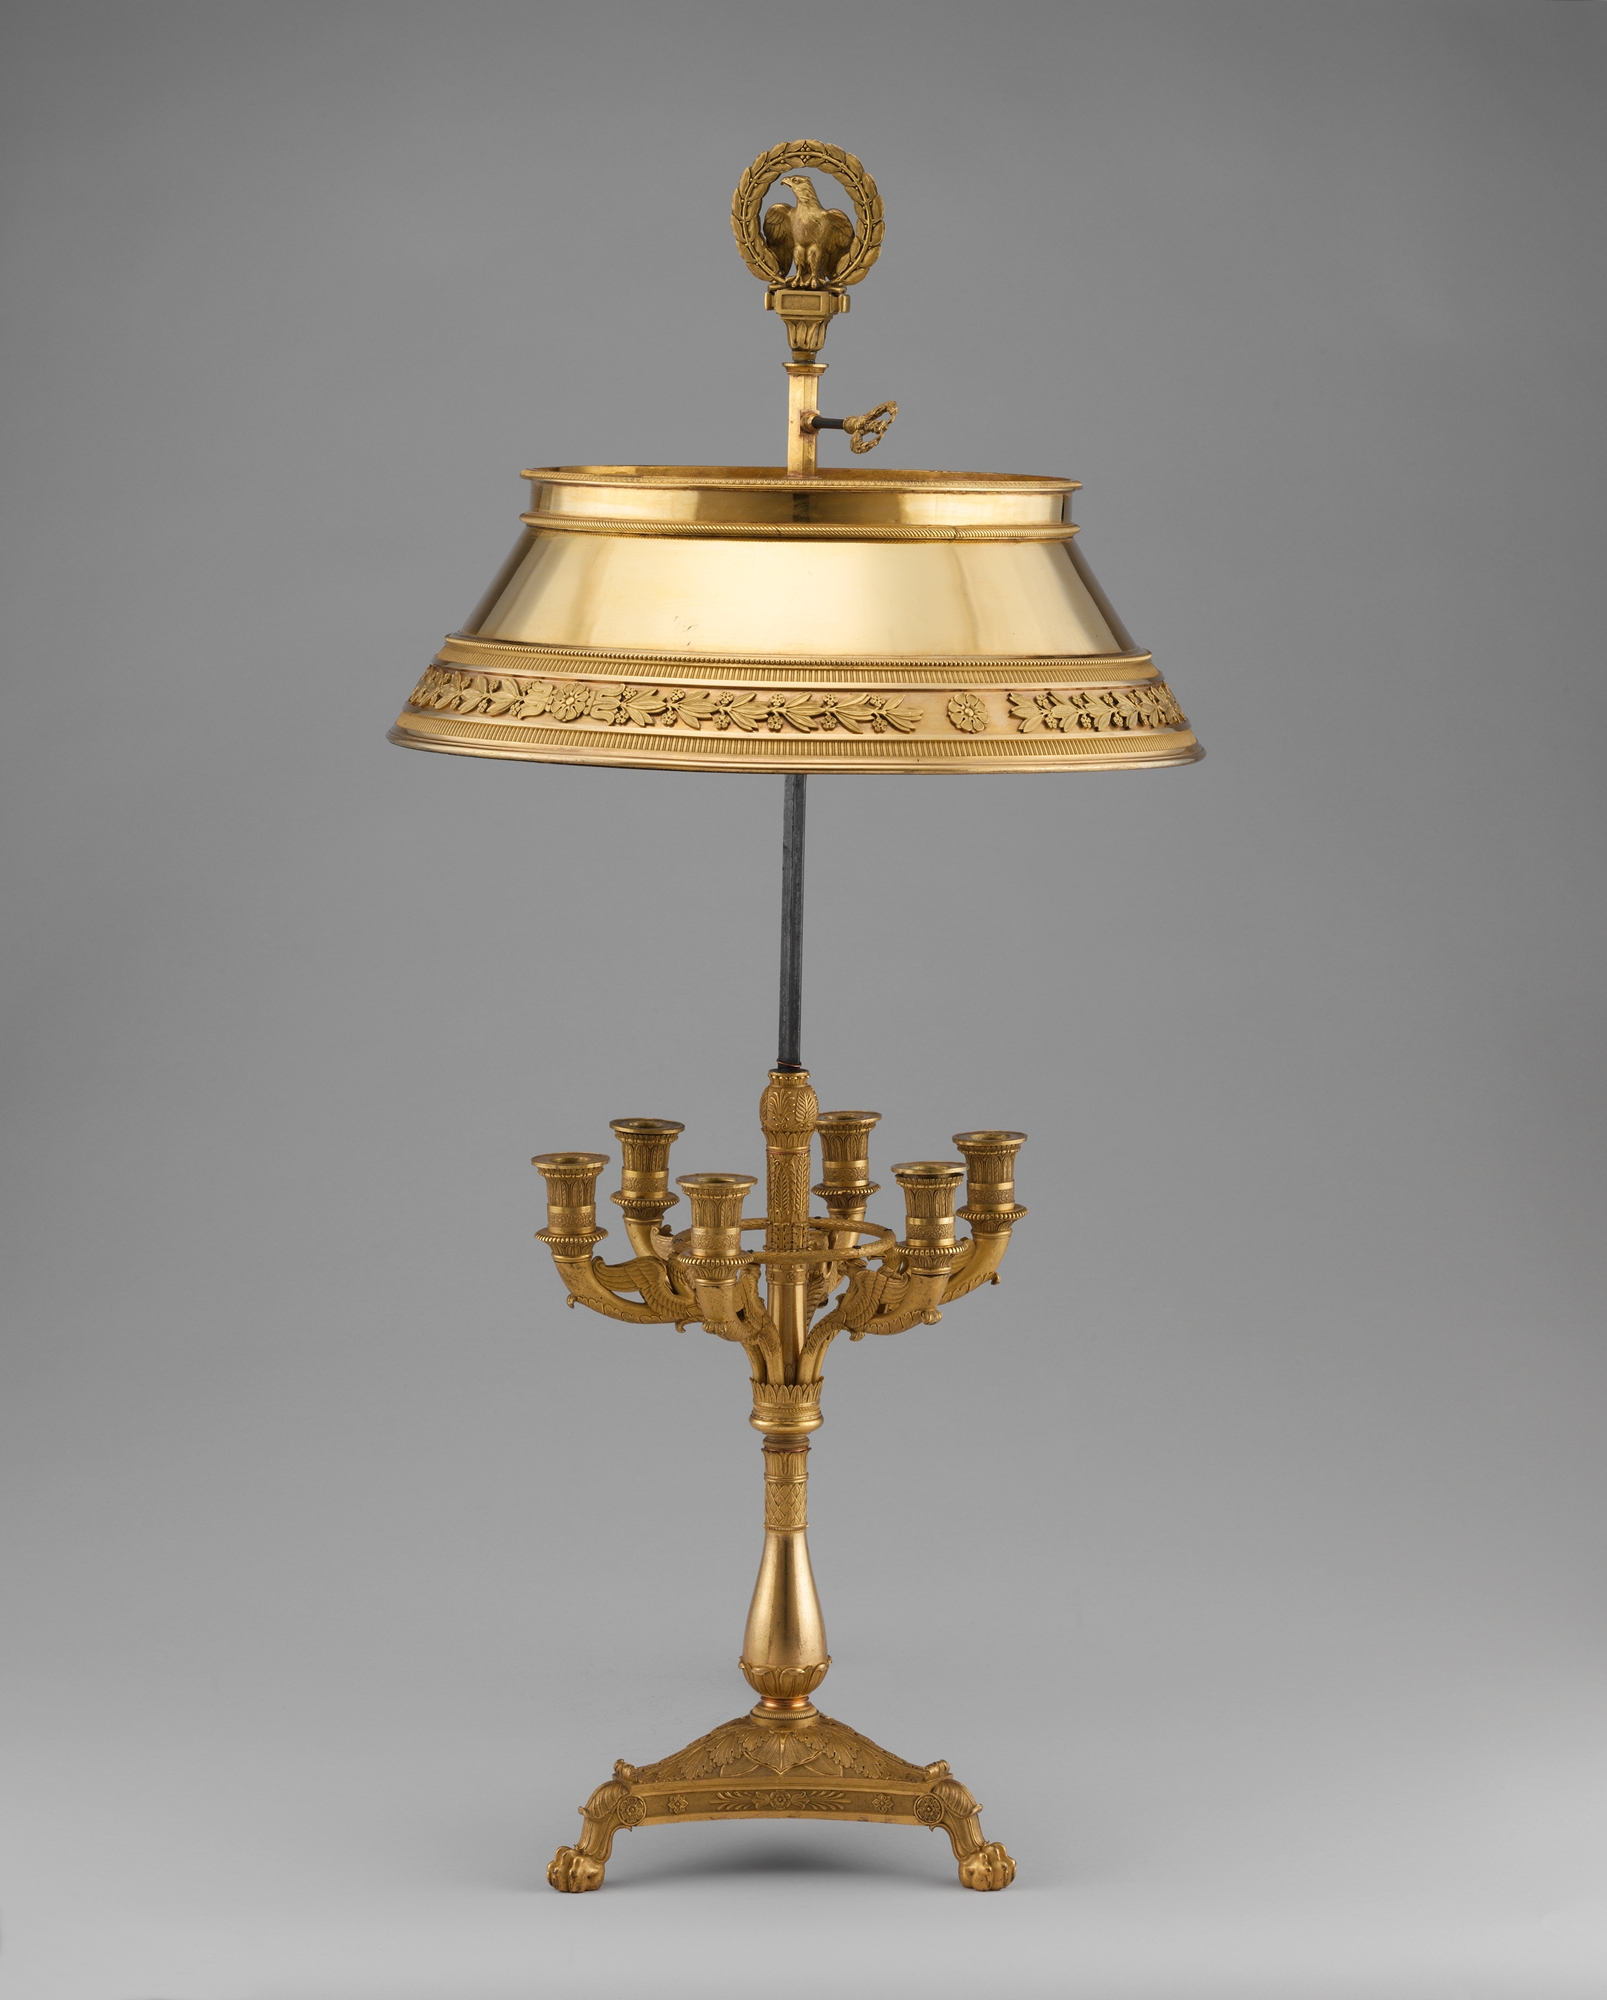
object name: candelabrum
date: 1801-1900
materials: gilt bronze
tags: eagles